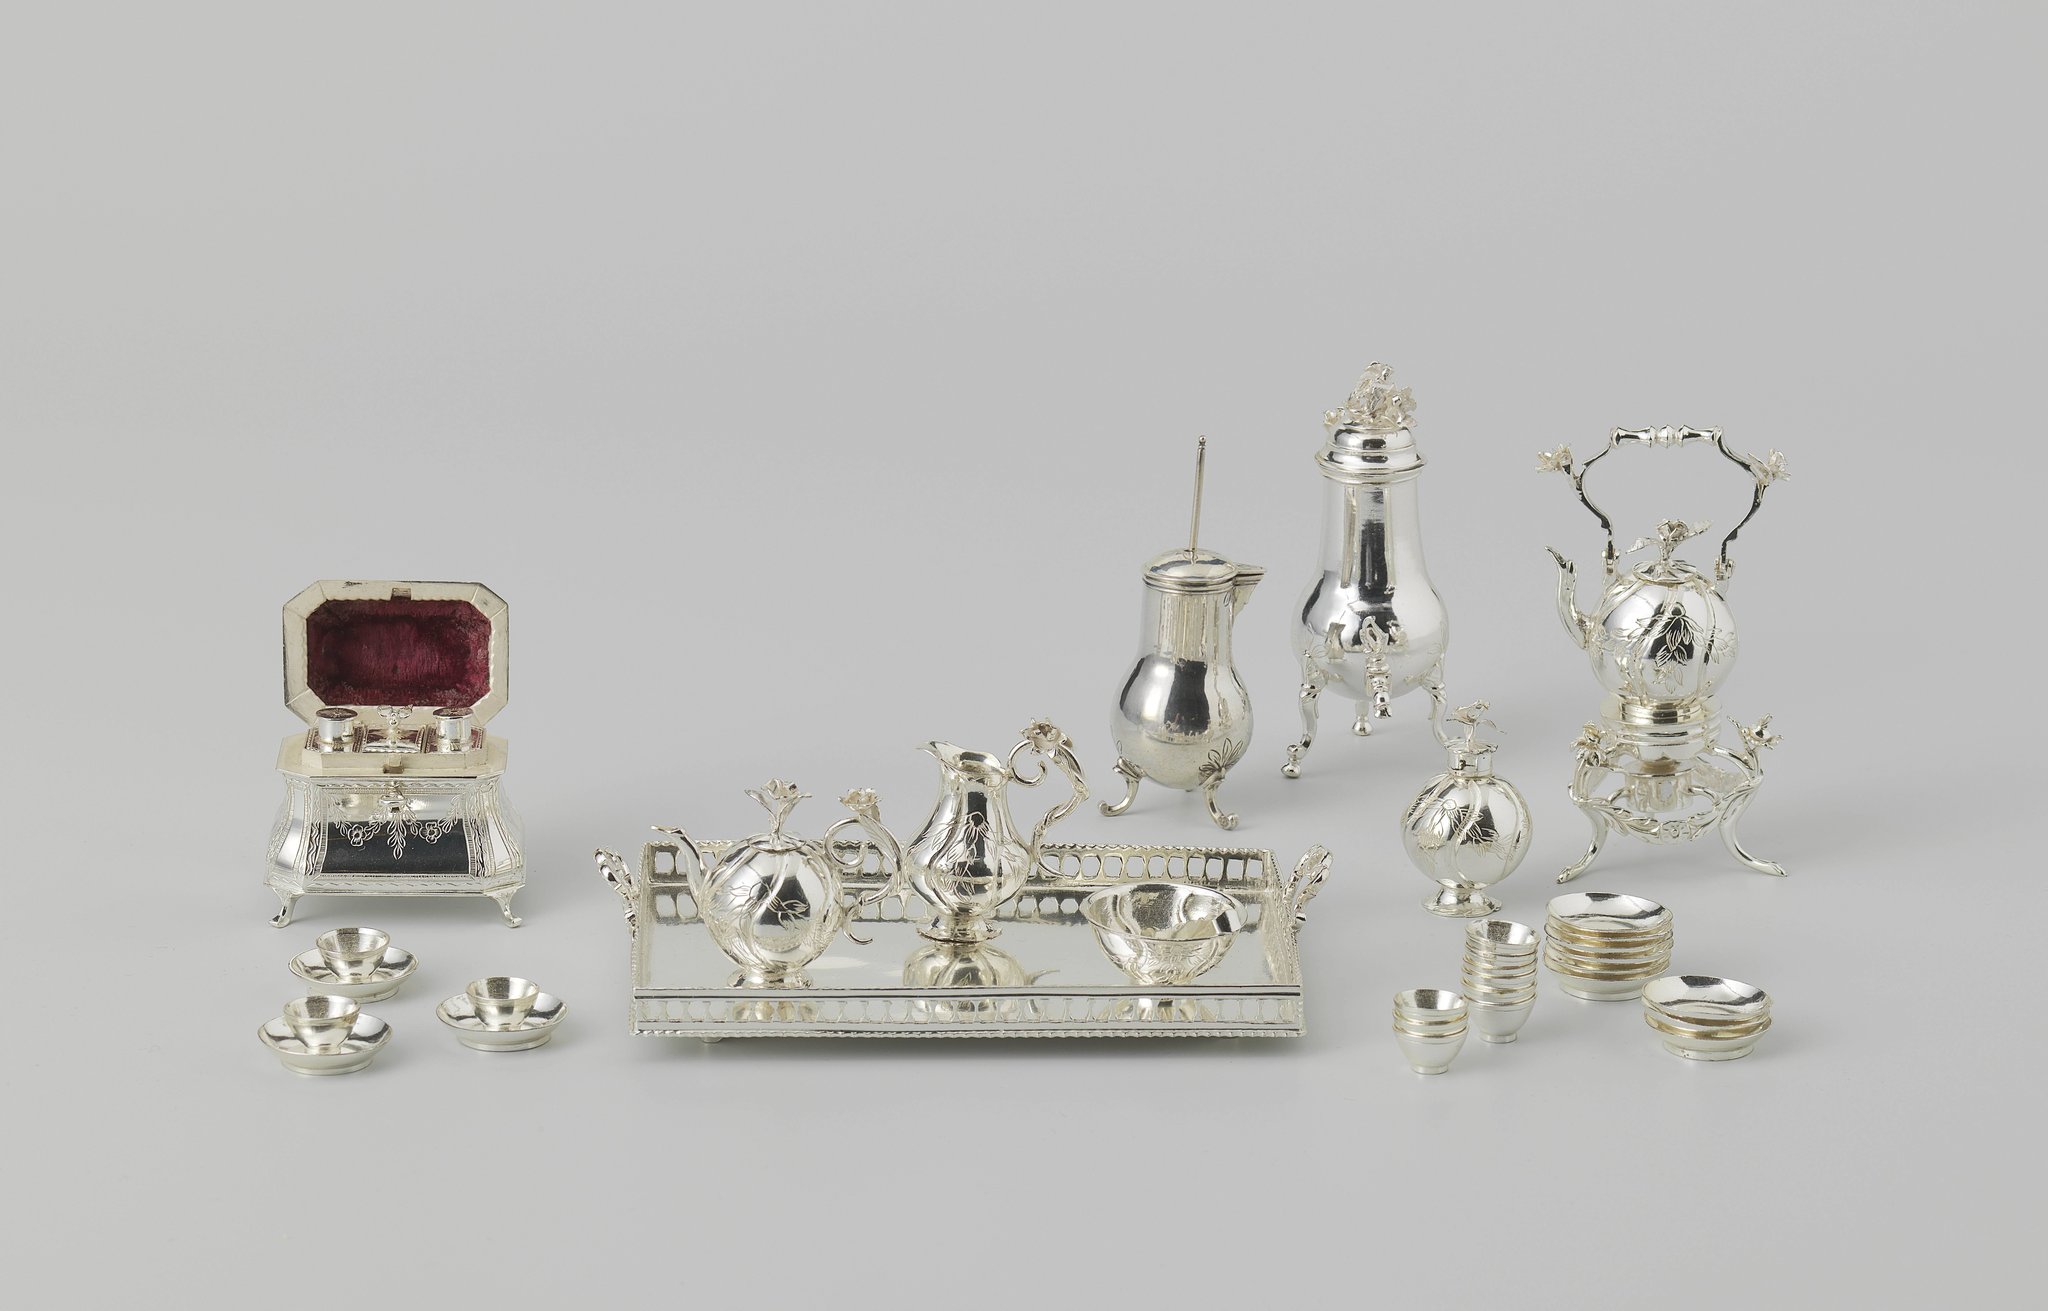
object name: miniature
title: Suikerkom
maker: hendrik duller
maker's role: silversmith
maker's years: 1749-1820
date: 1776-1811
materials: silver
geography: amsterdam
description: Ronde suikerkom op een voet. De wand van de kom heeft ingegroefde nerven en is gegraveerd met bloemen en bladerranken. De suikerkom is niet gemerkt. In de suikerkom wordt een suikertang bewaard (BK-NM-11177-142-q). De suikerkom wordt bewaard als onderdeel van een theeservies (BK-NM-11177-142).